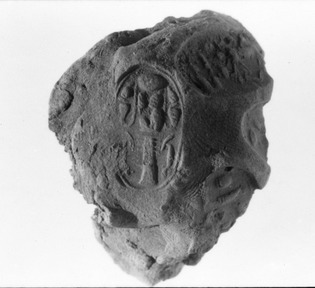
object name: sealing, nebmaatre, amenhotep iii, heb sed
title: Document Sealing With Multiple Seal Impressions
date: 1390-1352 BCE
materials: mud